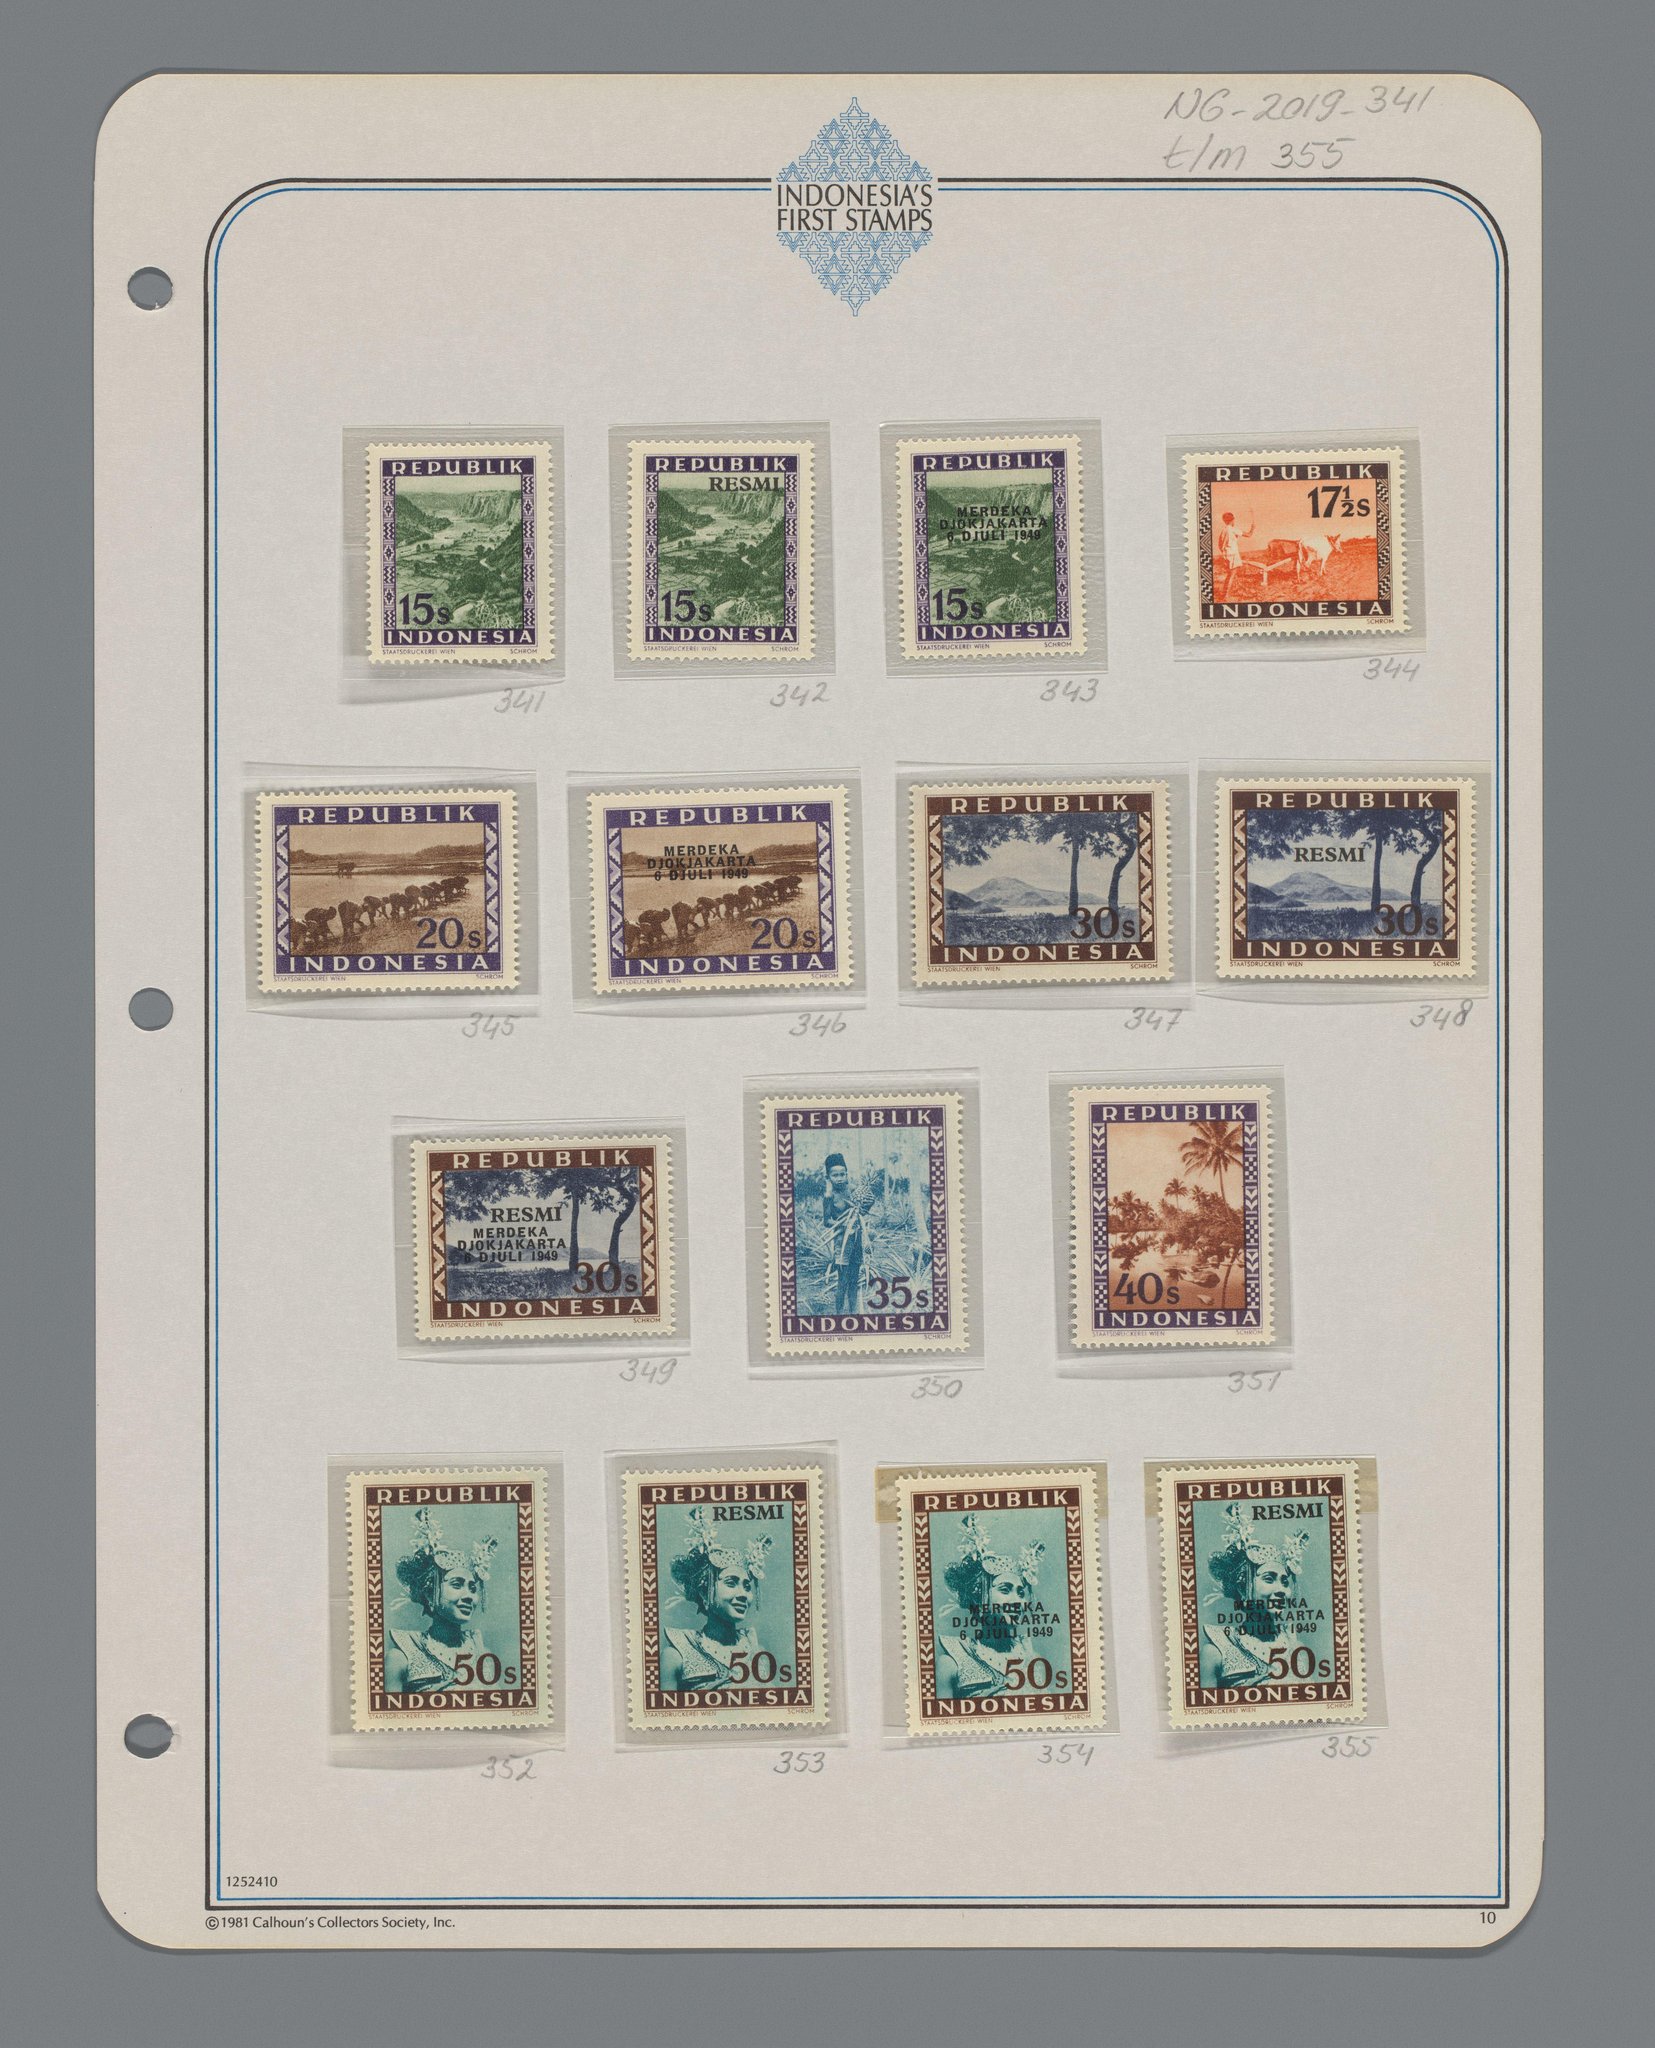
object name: postage stamp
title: Postzegel Republik Indonesia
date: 1949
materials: paper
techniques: photoaquatint, engraving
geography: philadelphia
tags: indonesia